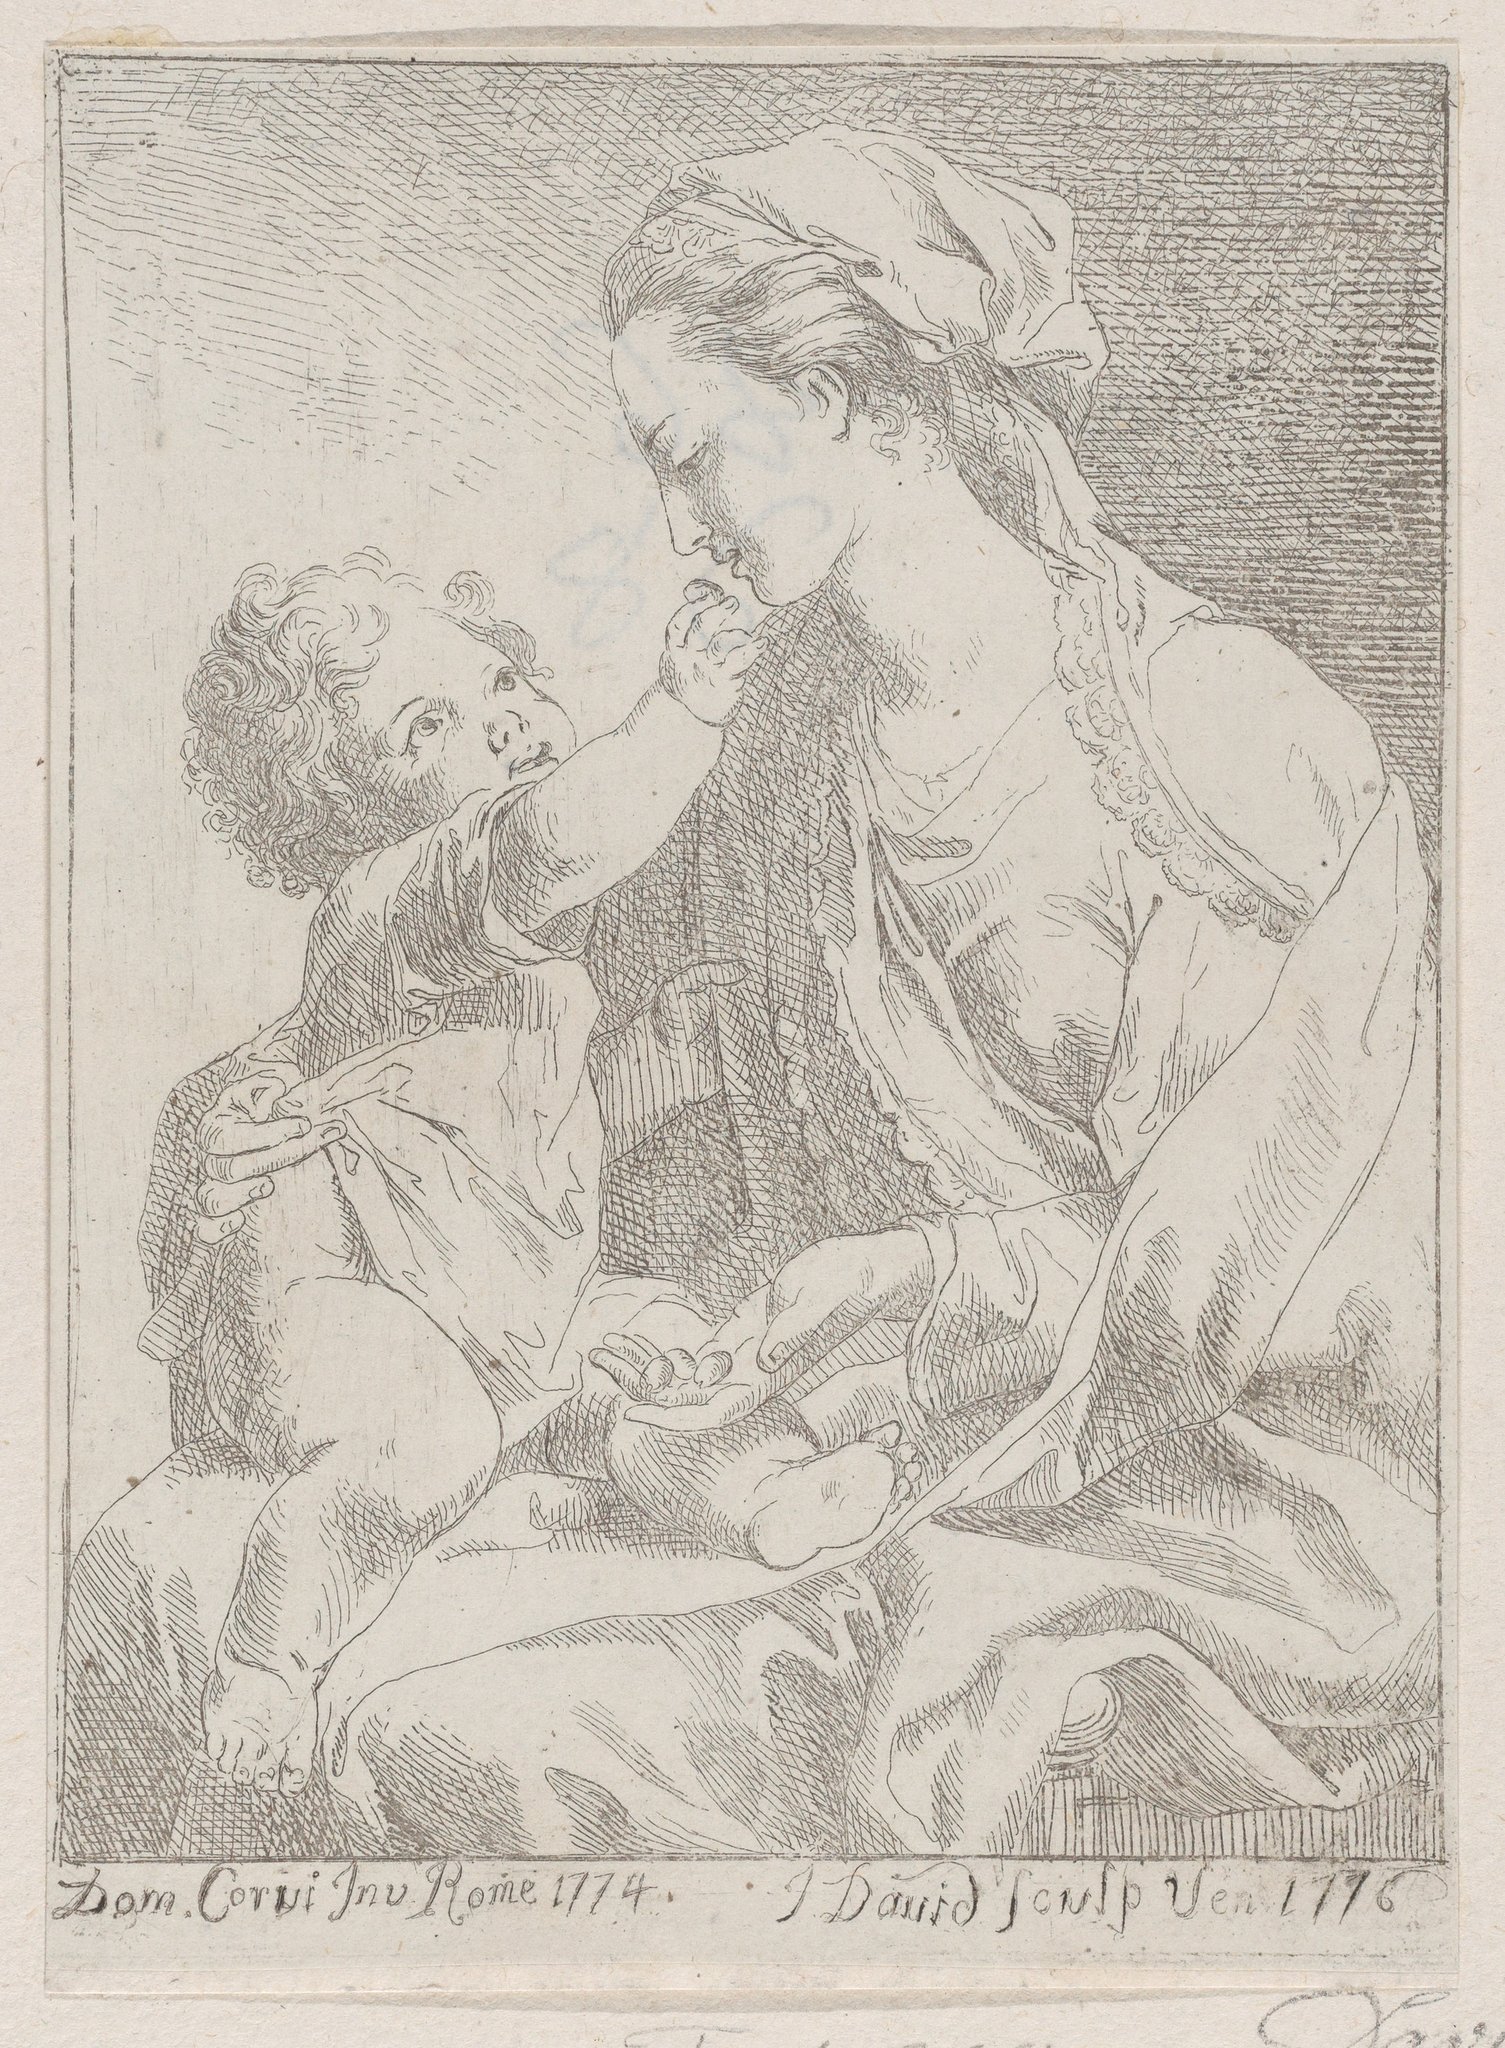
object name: print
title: Virgin and Child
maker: giovanni david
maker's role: artist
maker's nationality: italian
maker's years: 1749-1790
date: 1776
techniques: etching